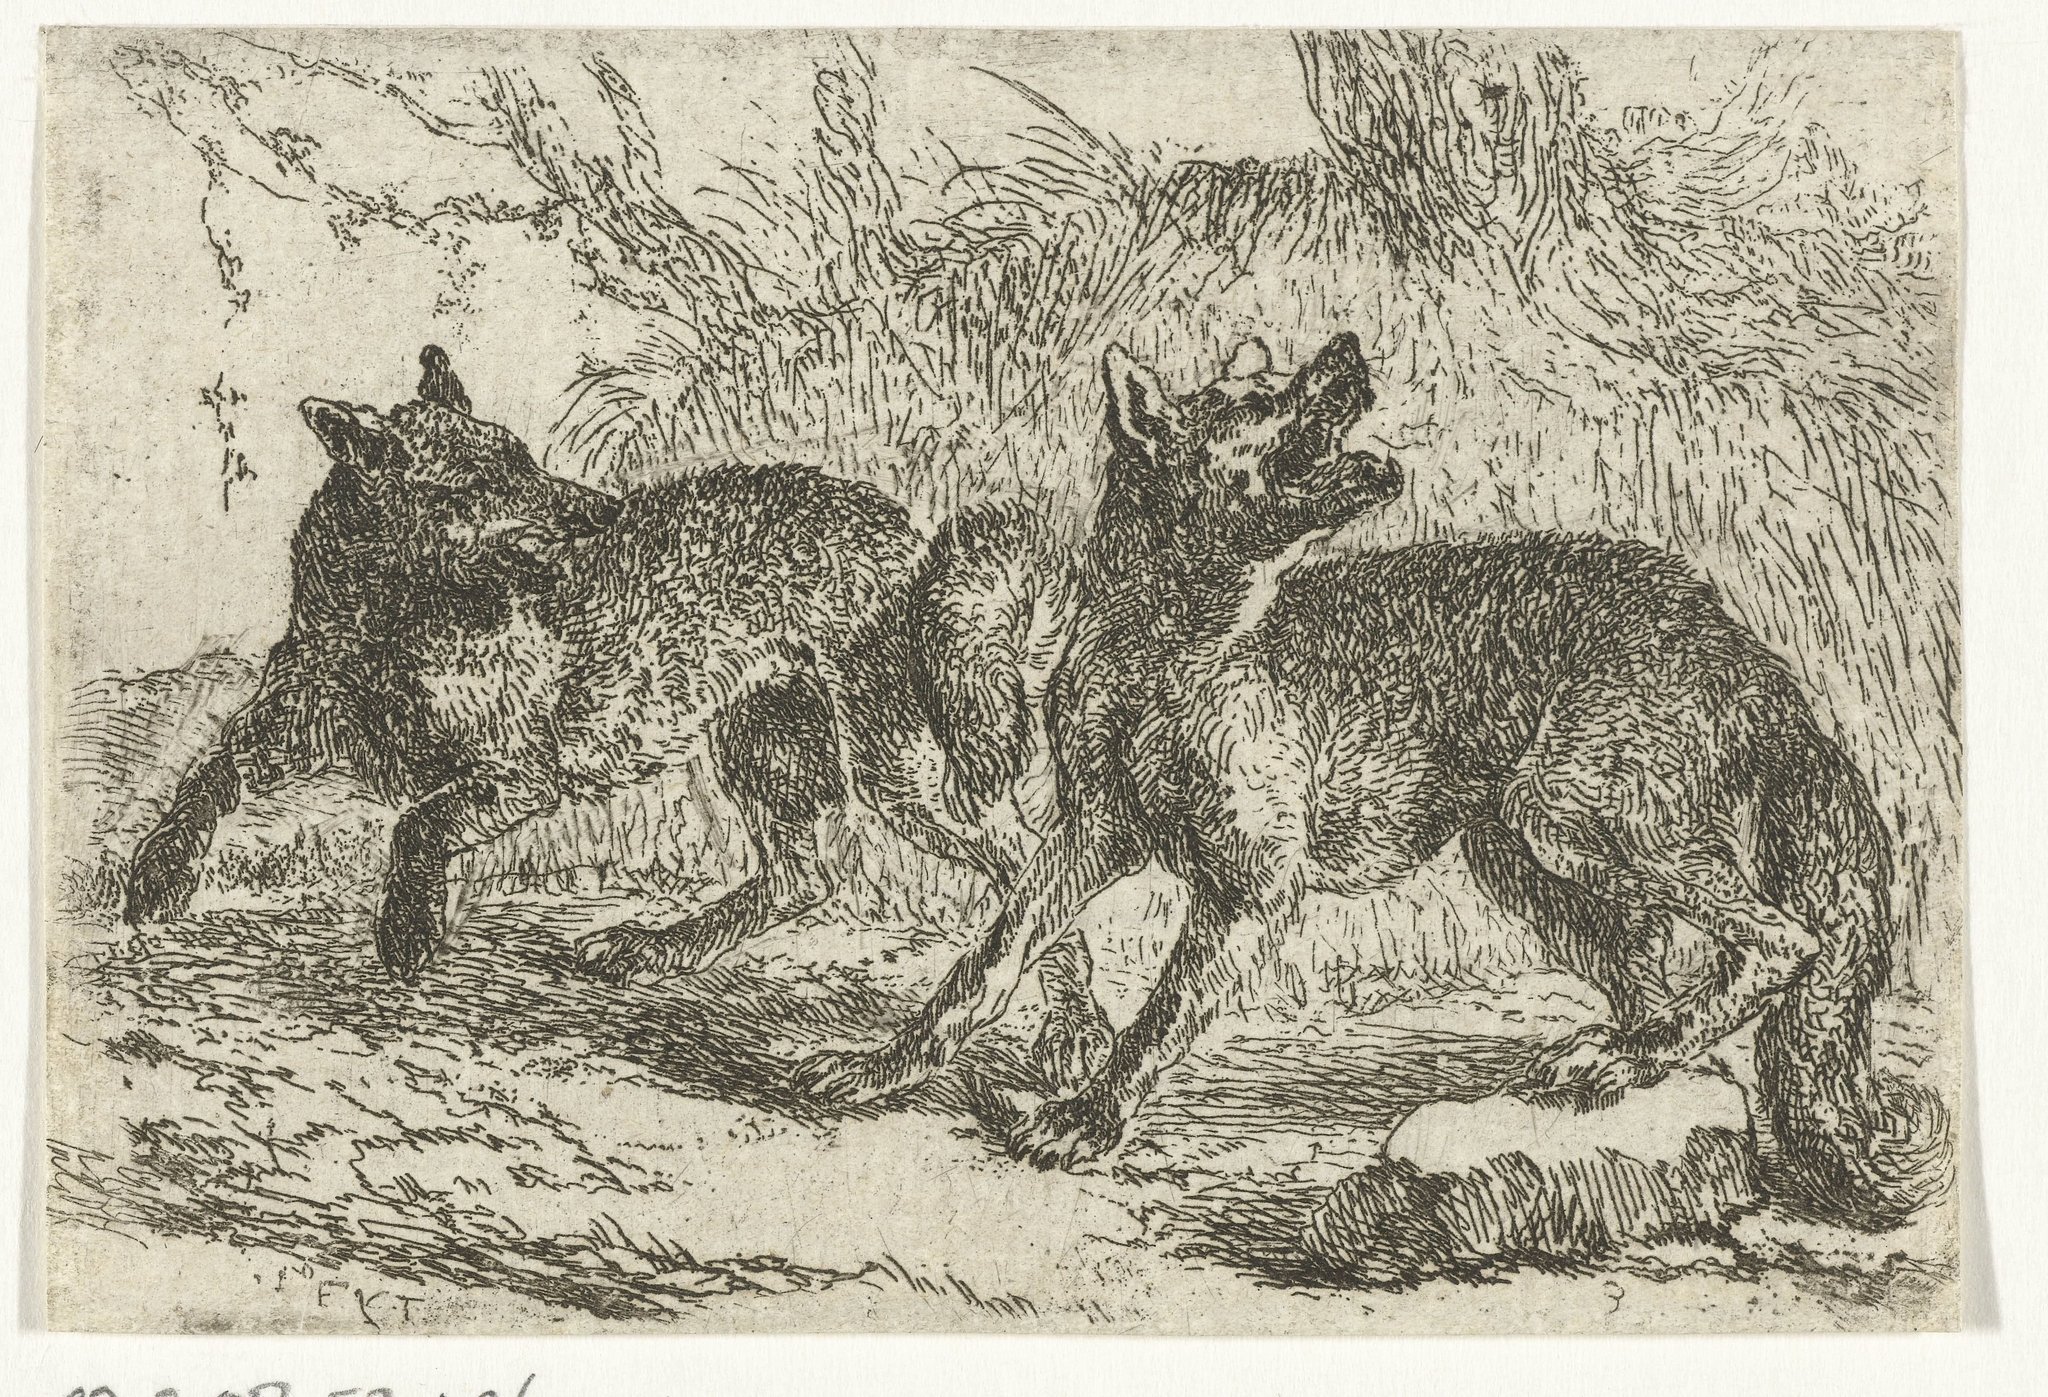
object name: print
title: Dieren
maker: joannes fijt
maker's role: draughtsman, print maker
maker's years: 1611-1661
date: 1621-1661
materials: paper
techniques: etching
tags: beasts of prey, predatory animals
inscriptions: collector's mark: Lugt 2228